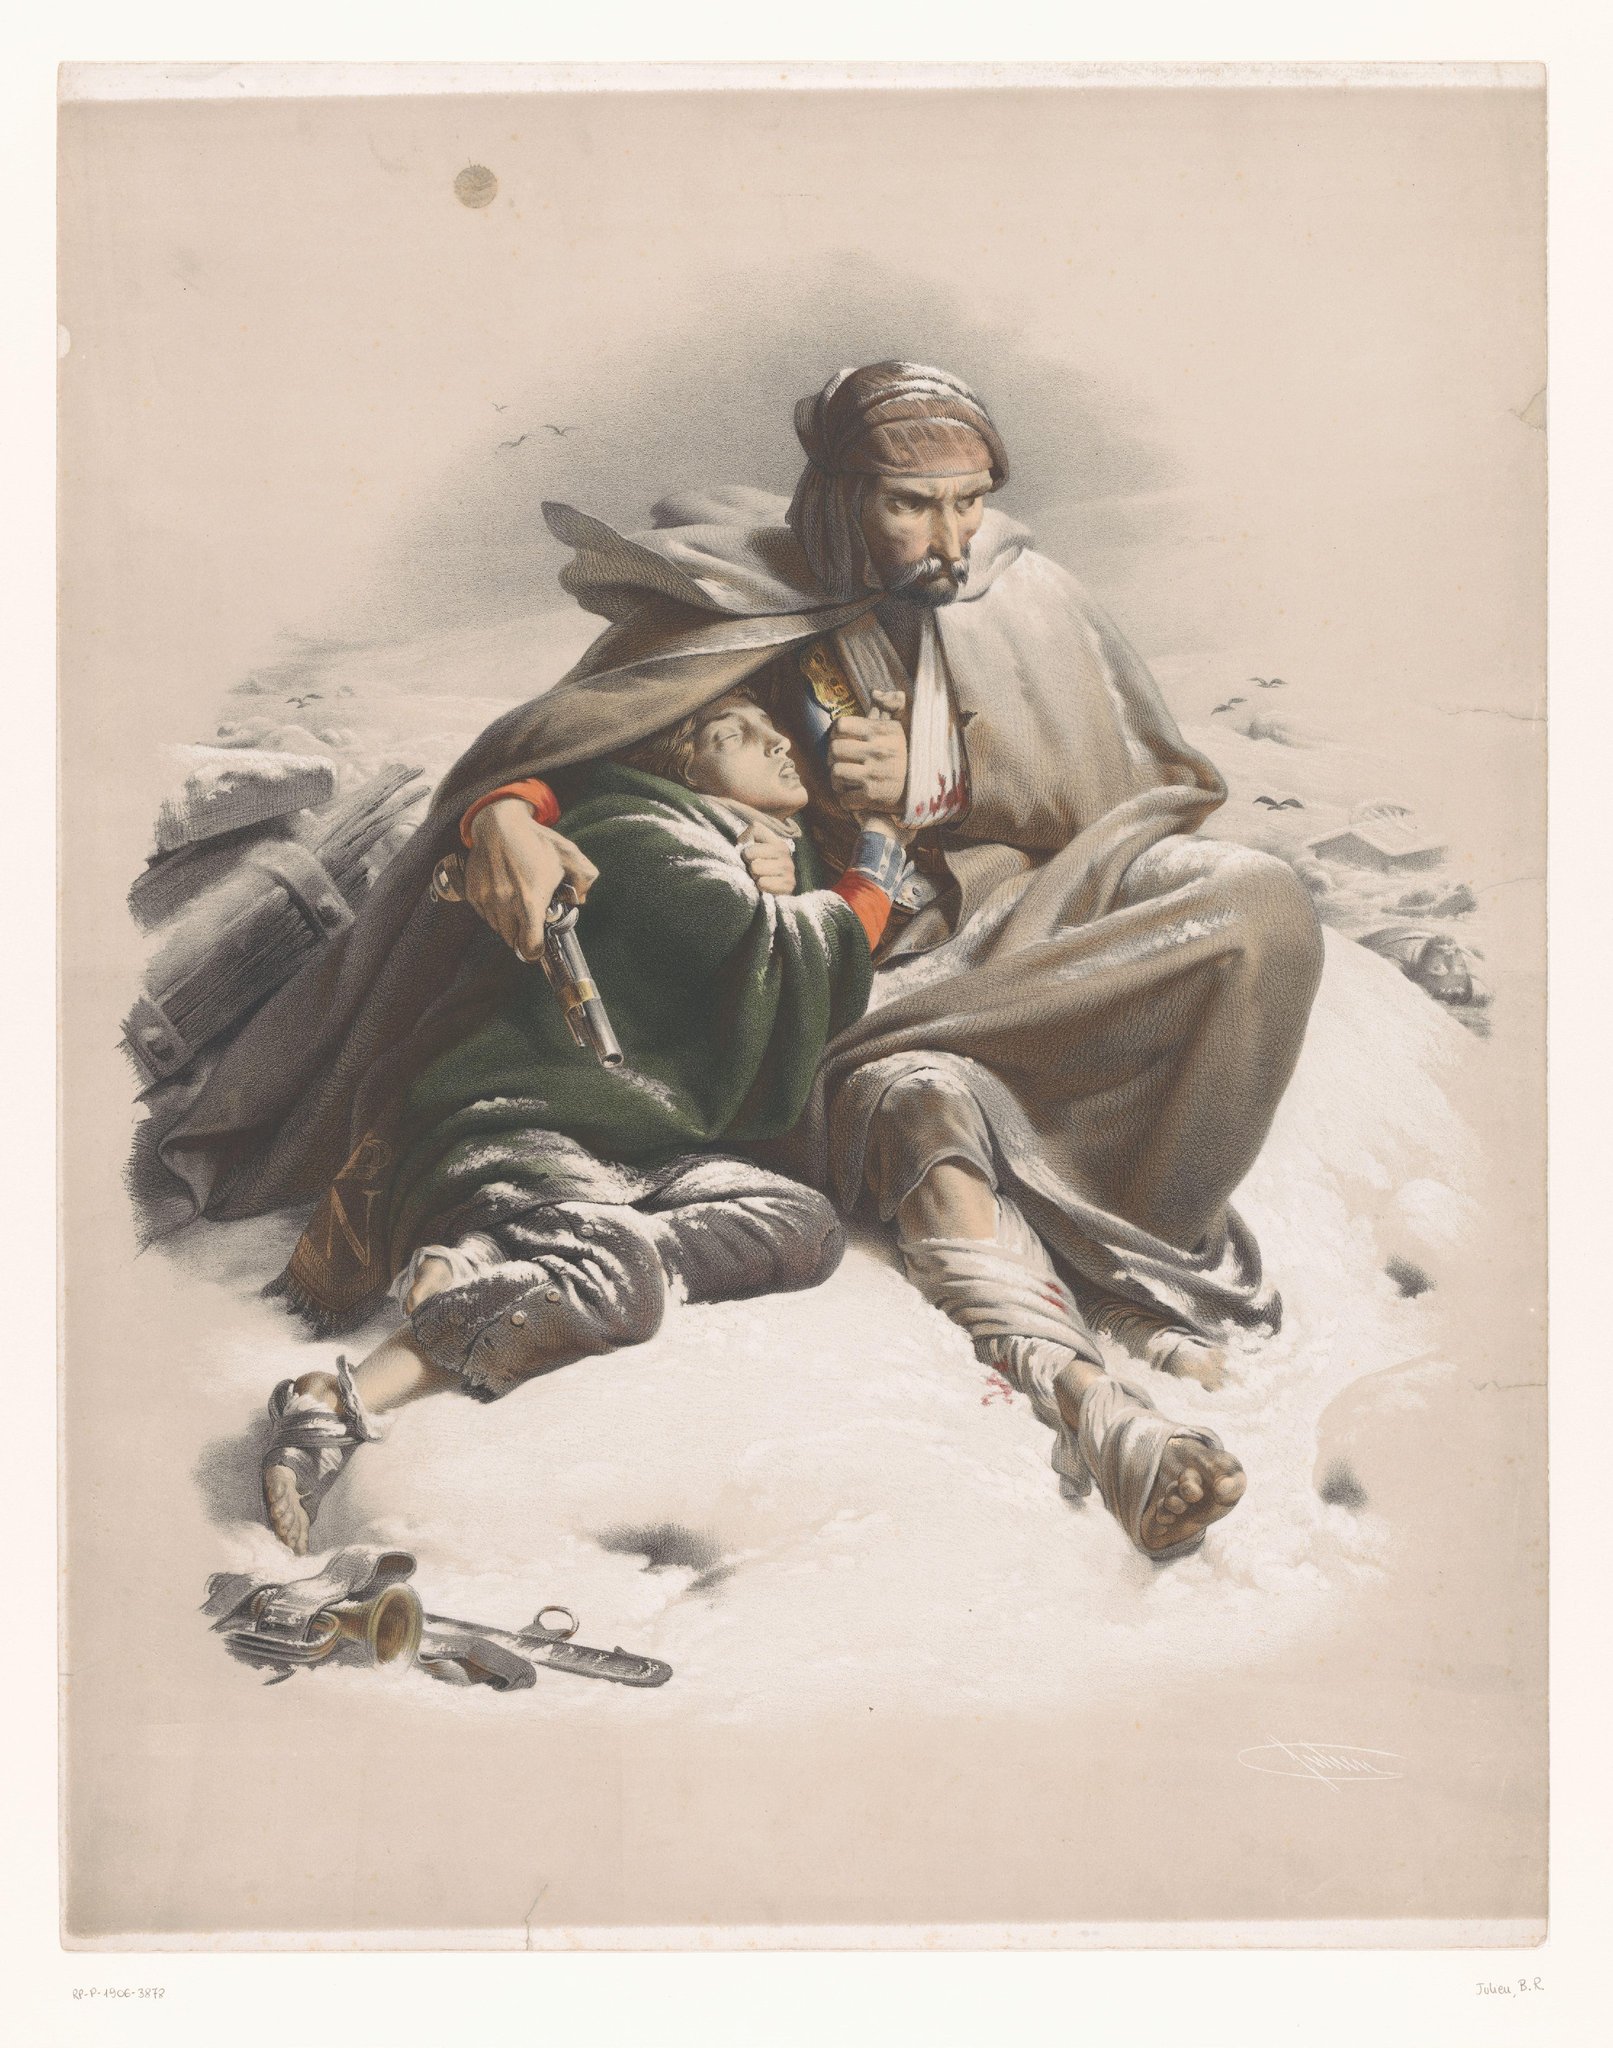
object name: print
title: Gewonde soldaten in een winterlandschap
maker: bernard romain julien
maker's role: print maker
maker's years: 1802-1871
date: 1812-1871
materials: paper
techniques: hand coloring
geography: france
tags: infections and wounds, winter landscape; landscape symbolizing winter (the four seasons of the year)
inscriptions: collector's mark: Lugt 2228